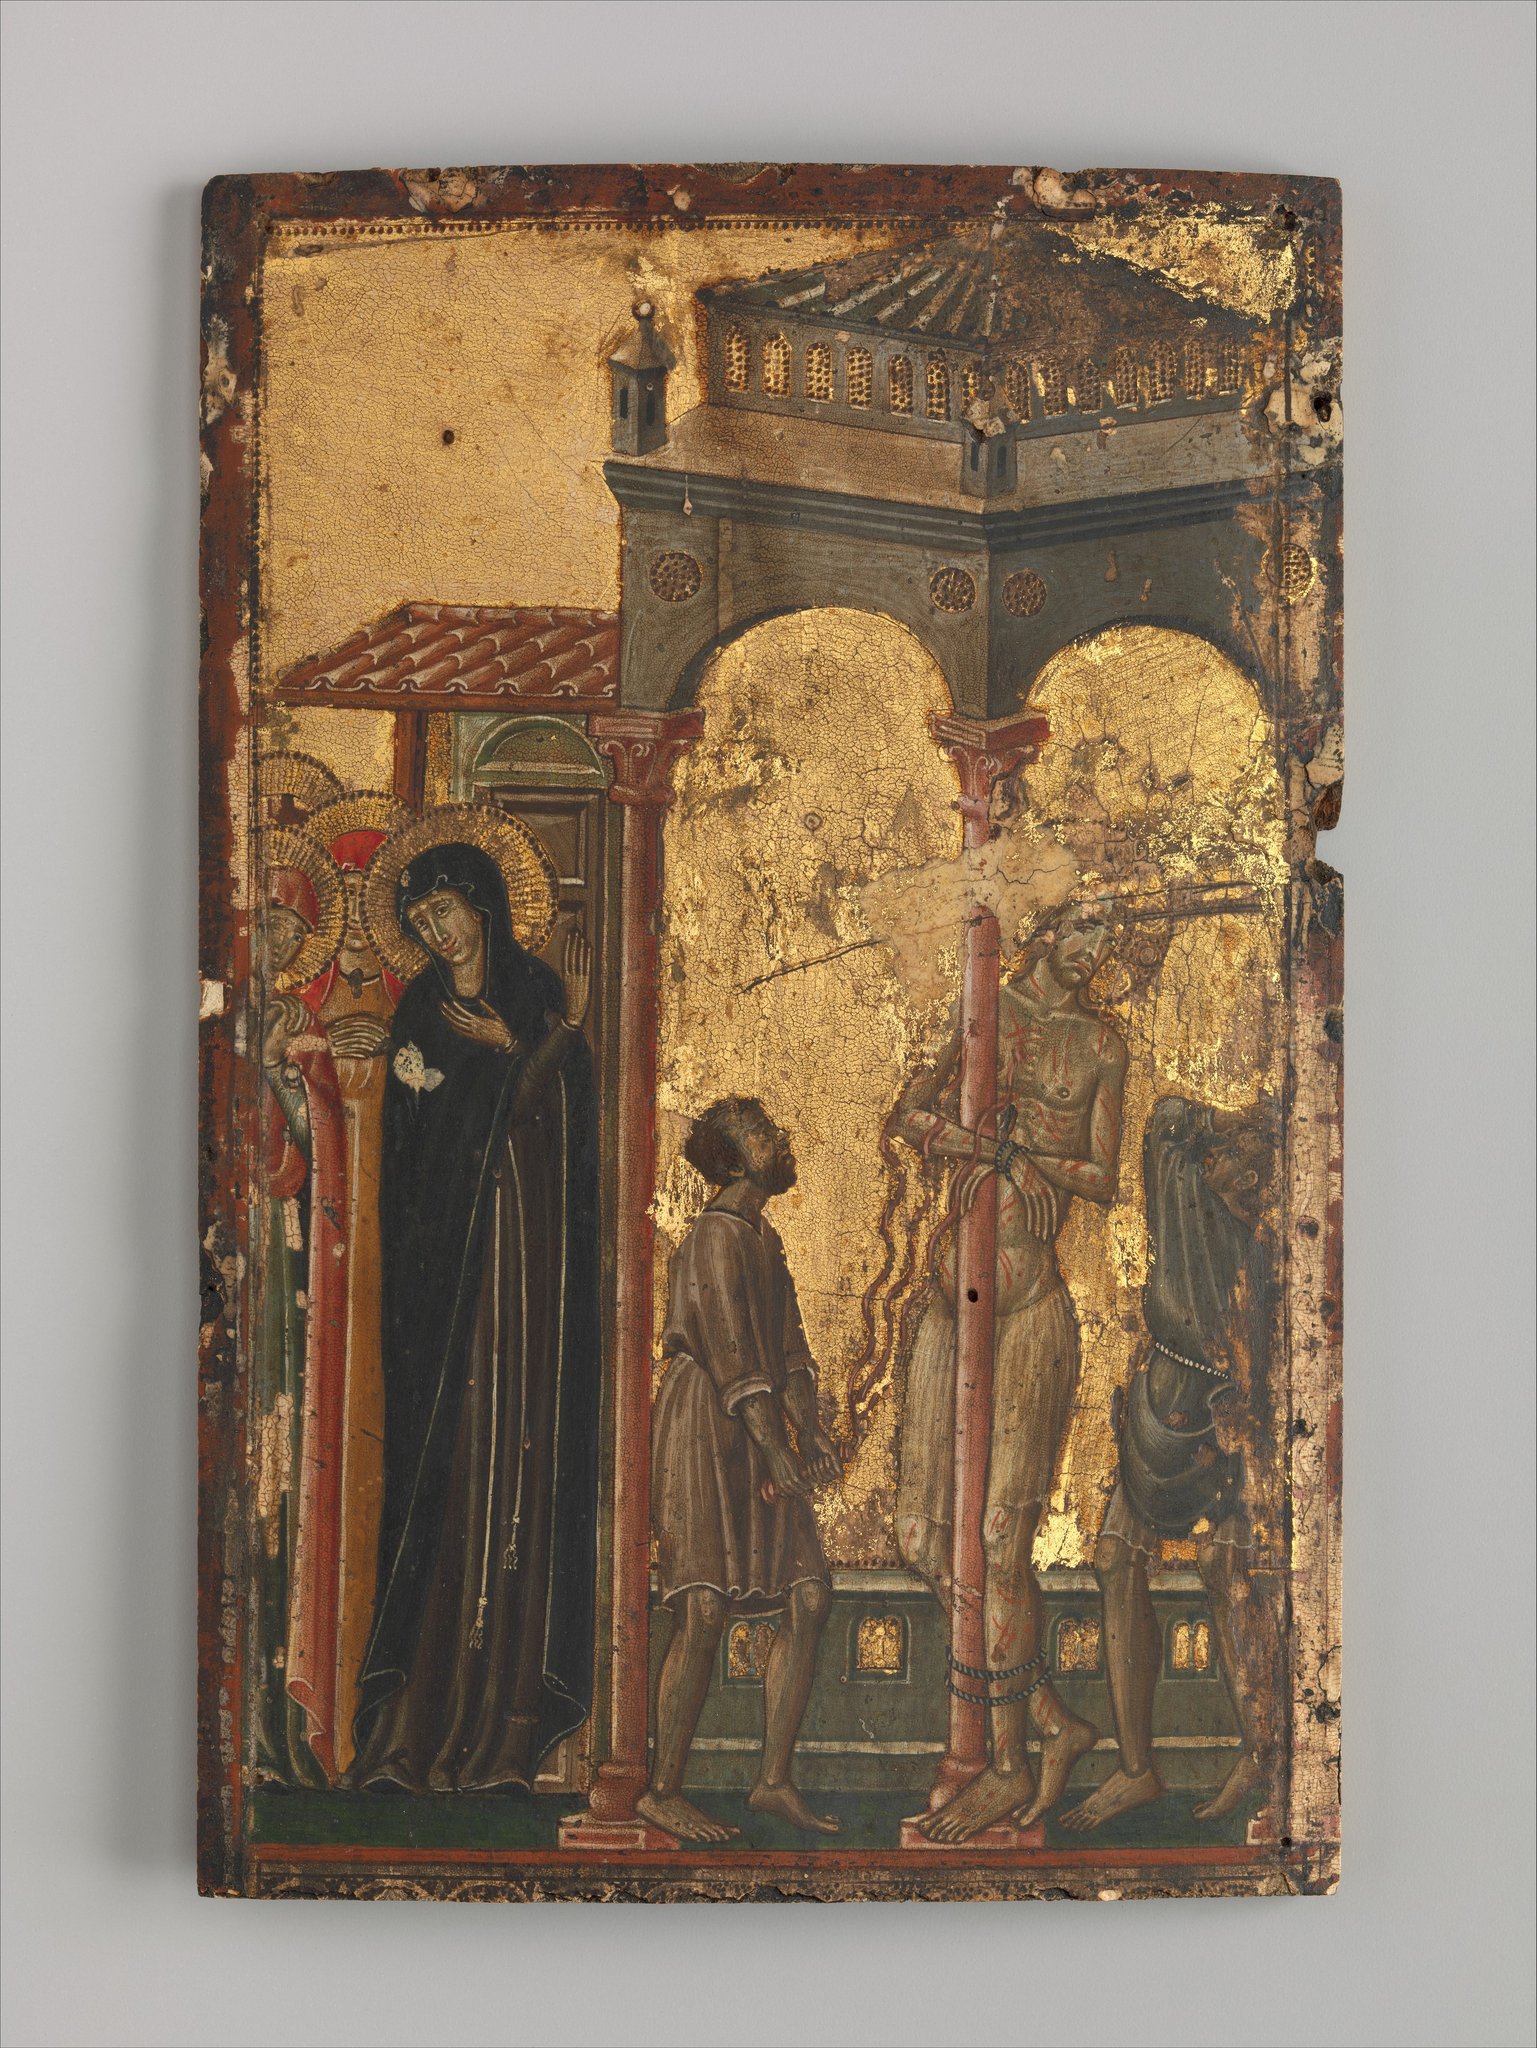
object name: painting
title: The Flagellation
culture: italian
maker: master of forlì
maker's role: artist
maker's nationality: italian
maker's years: 1300-1350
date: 1301-1350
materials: gold leaf, paint, wood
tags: men,women,christ